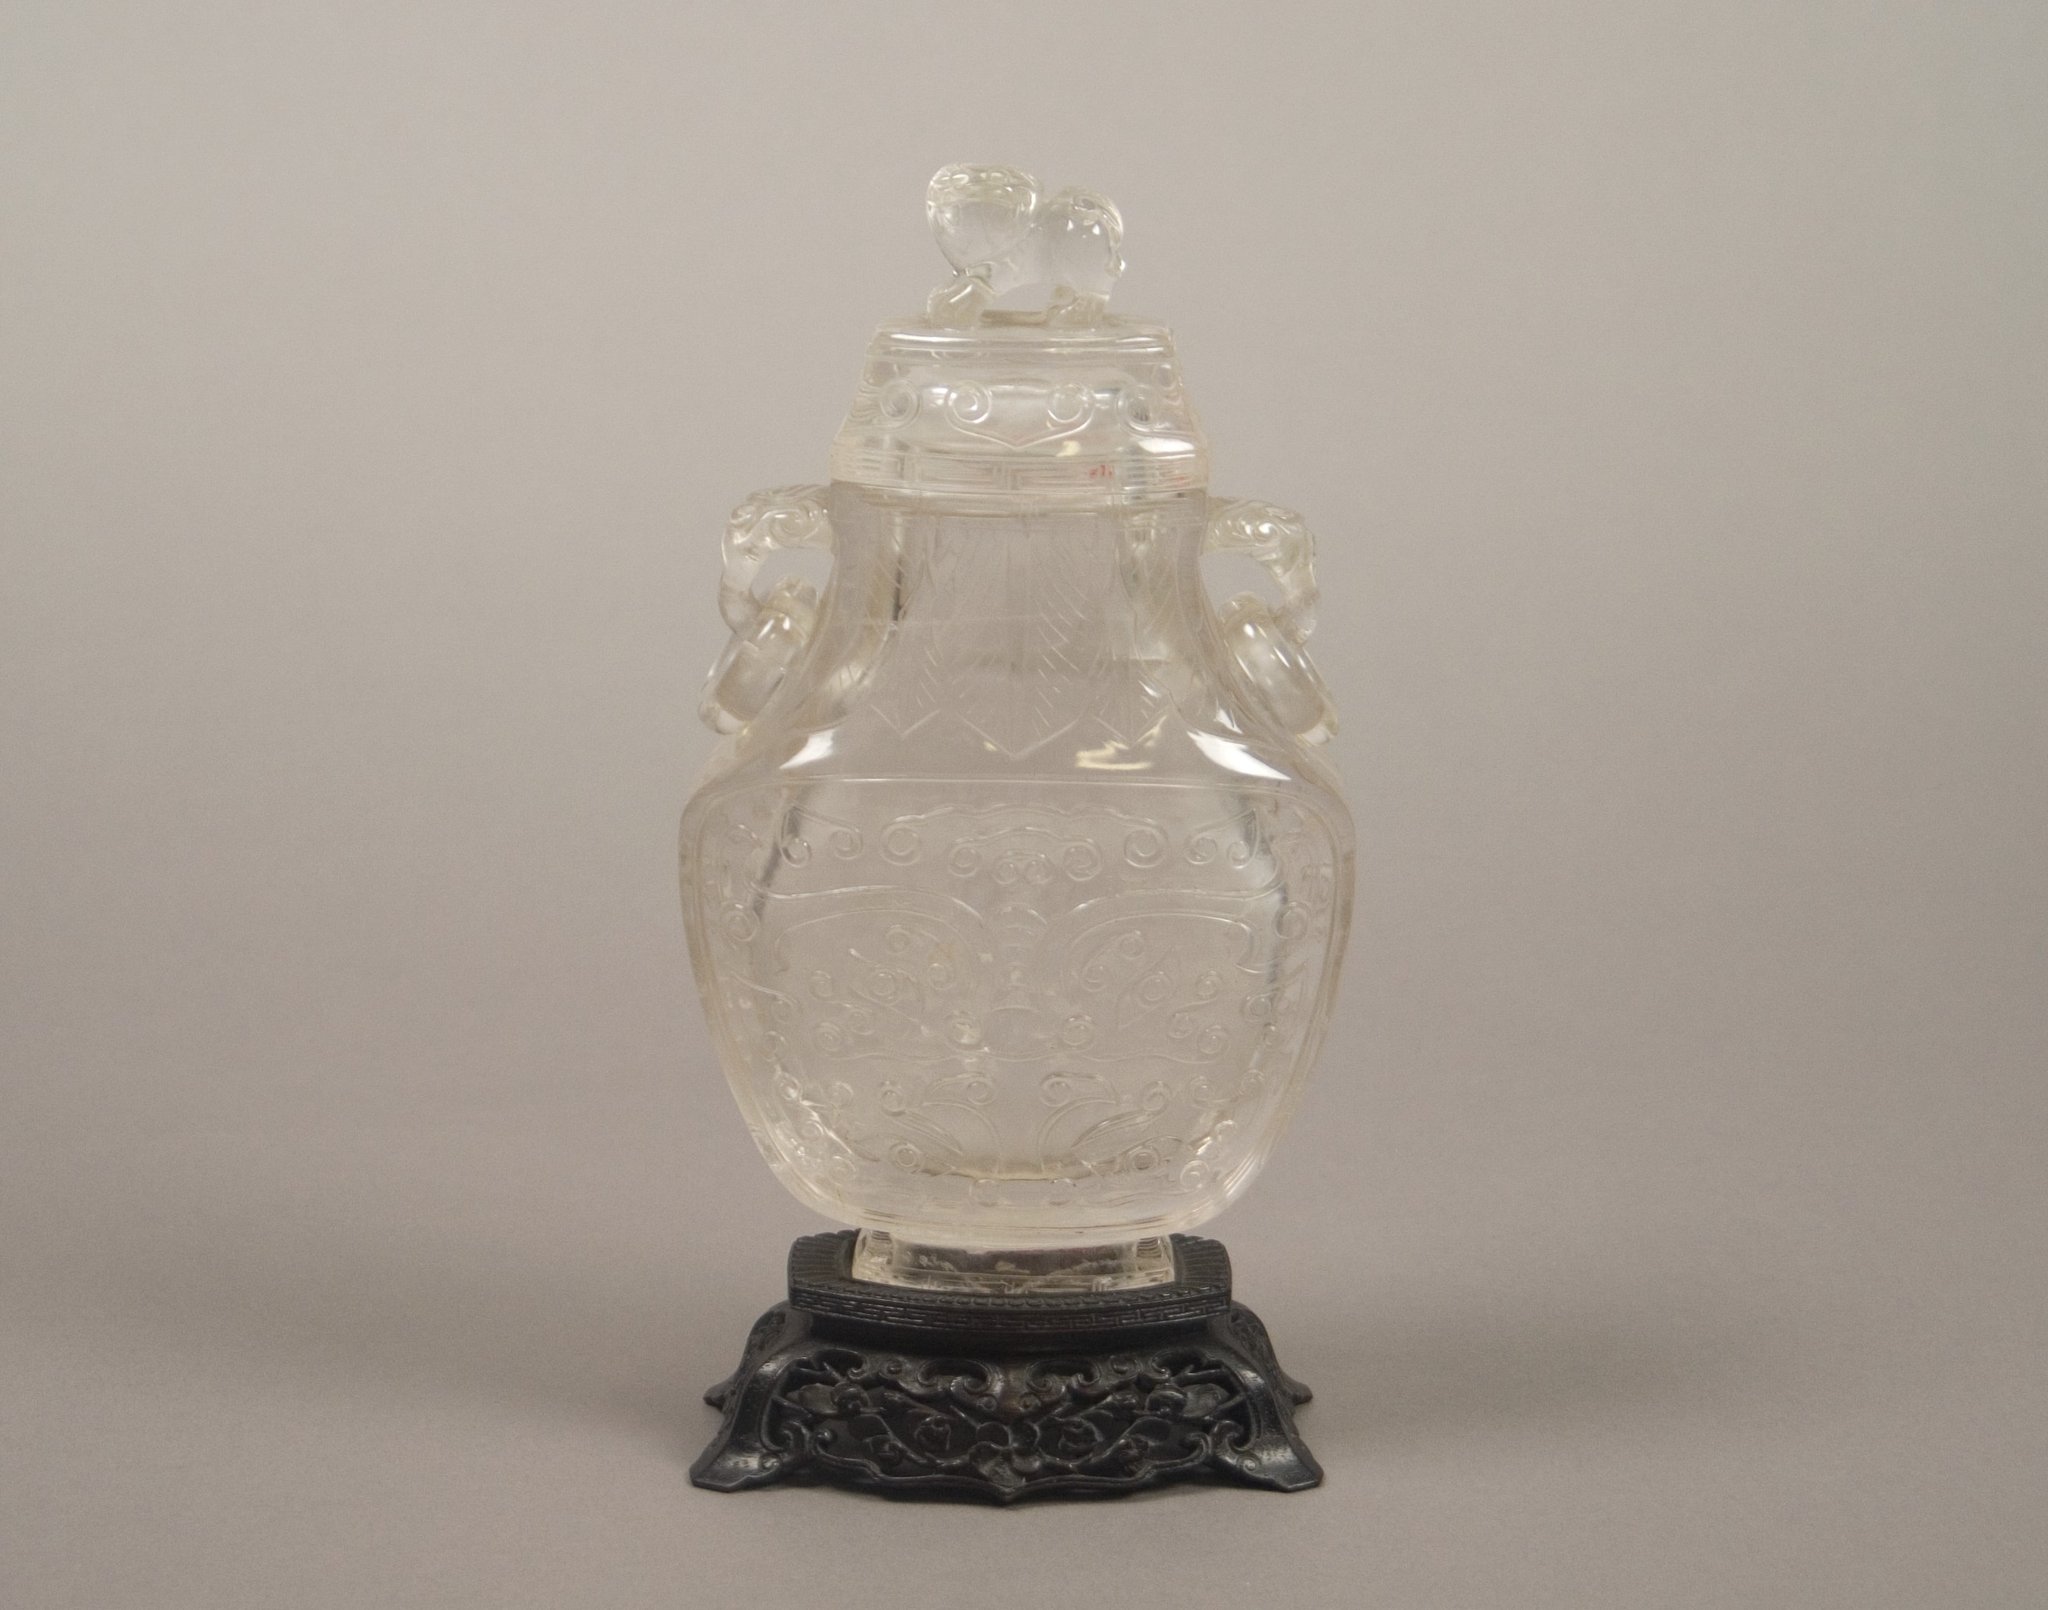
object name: covered vase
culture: chinese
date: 1701-1800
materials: quartz